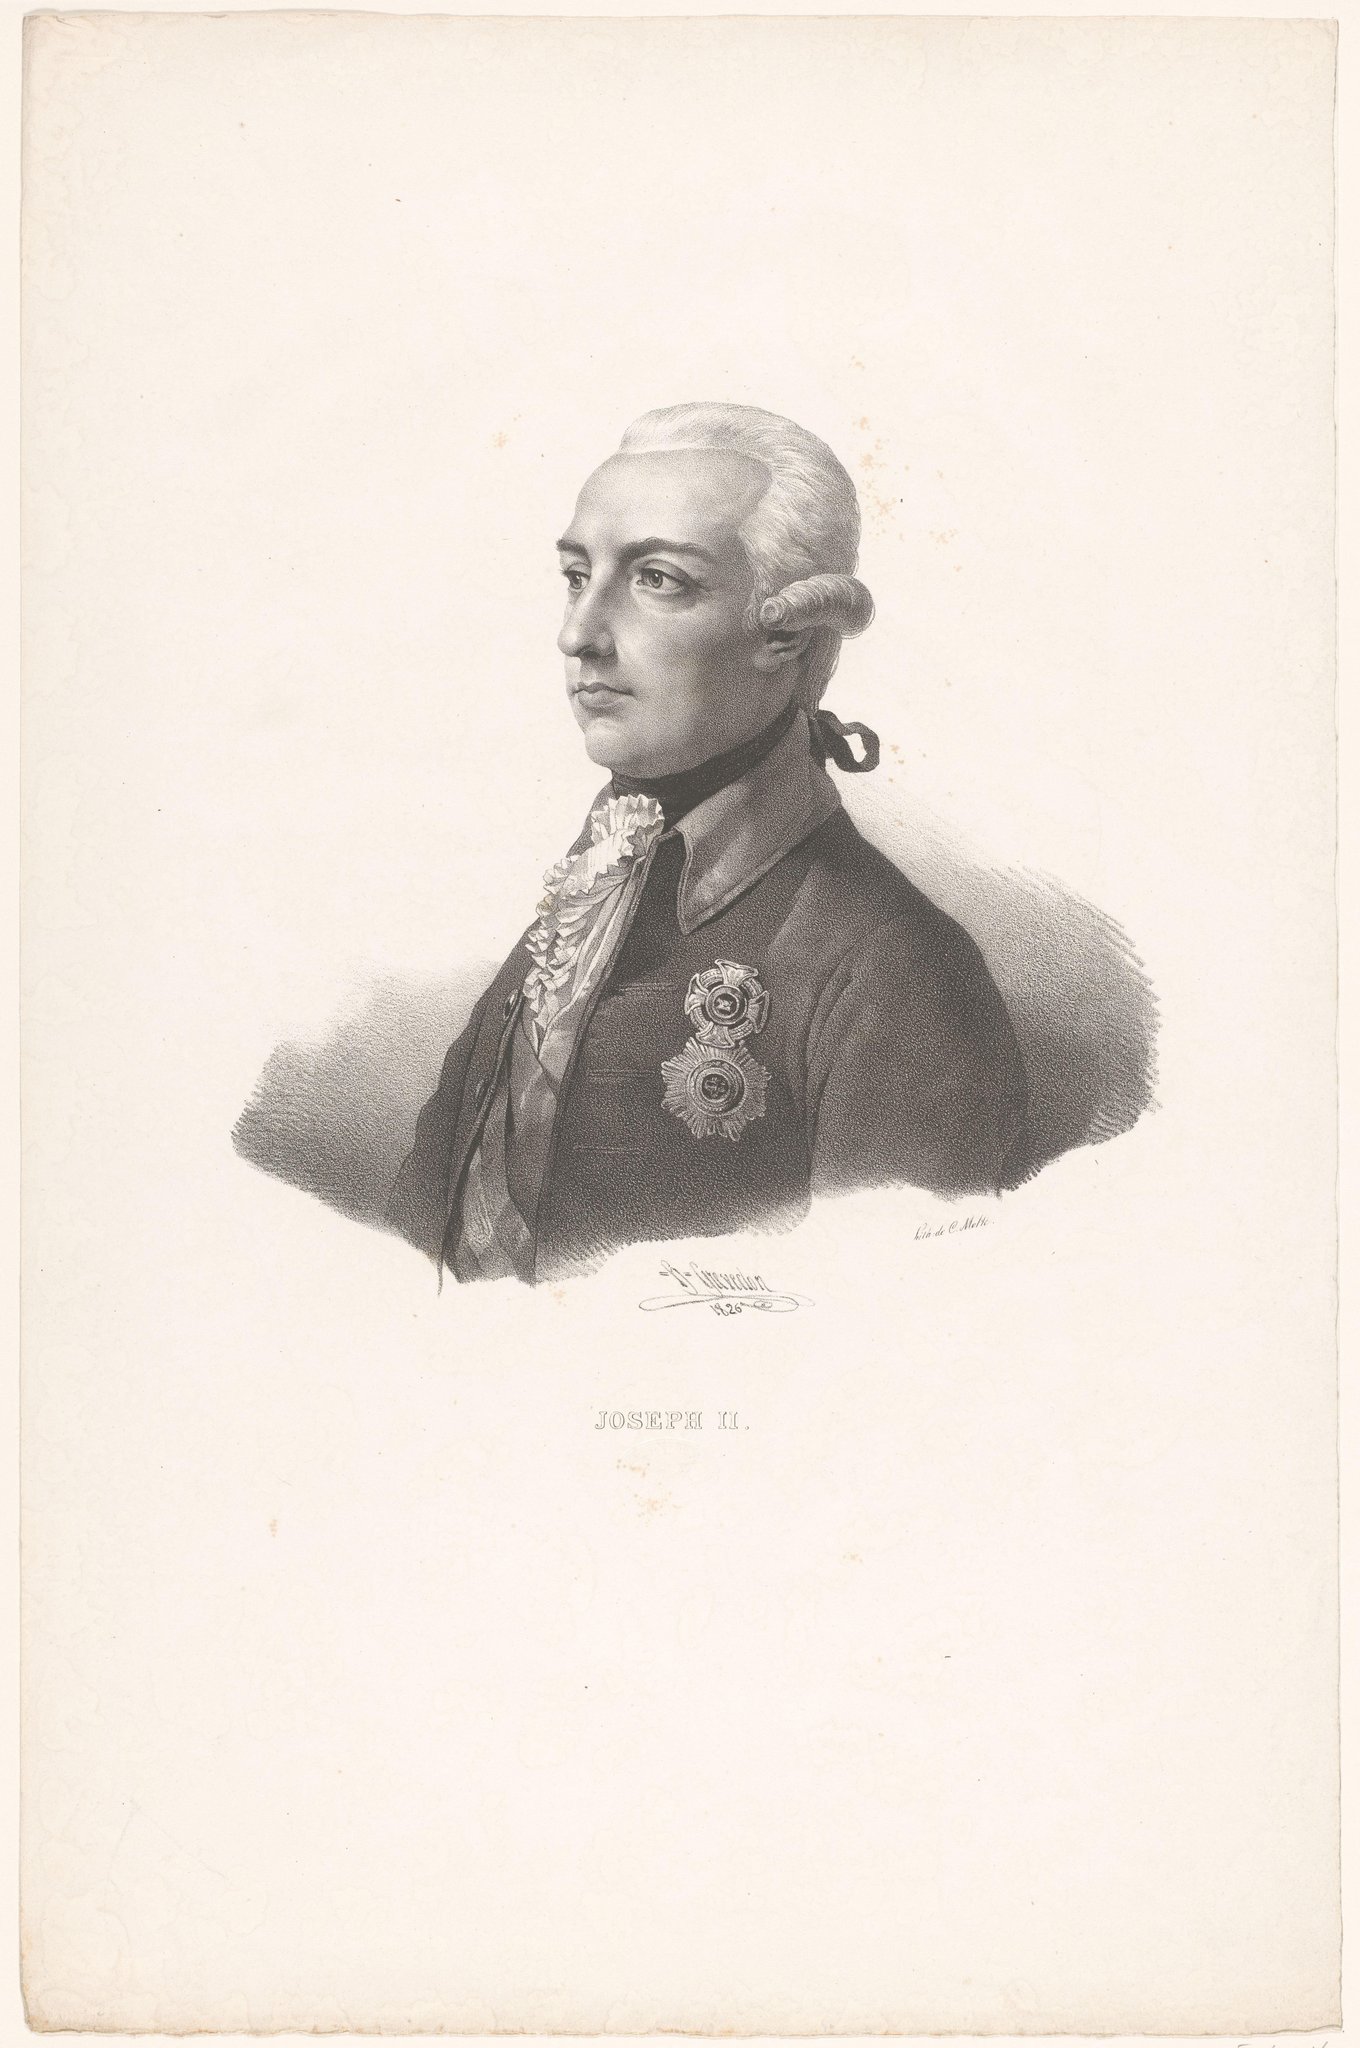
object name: print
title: Joseph II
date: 1826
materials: paper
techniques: lithograph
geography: paris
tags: vienna, jozef ii (duits keizer), historical persons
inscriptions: check stamp: Lugt 3996, collector's mark: Lugt 2228a